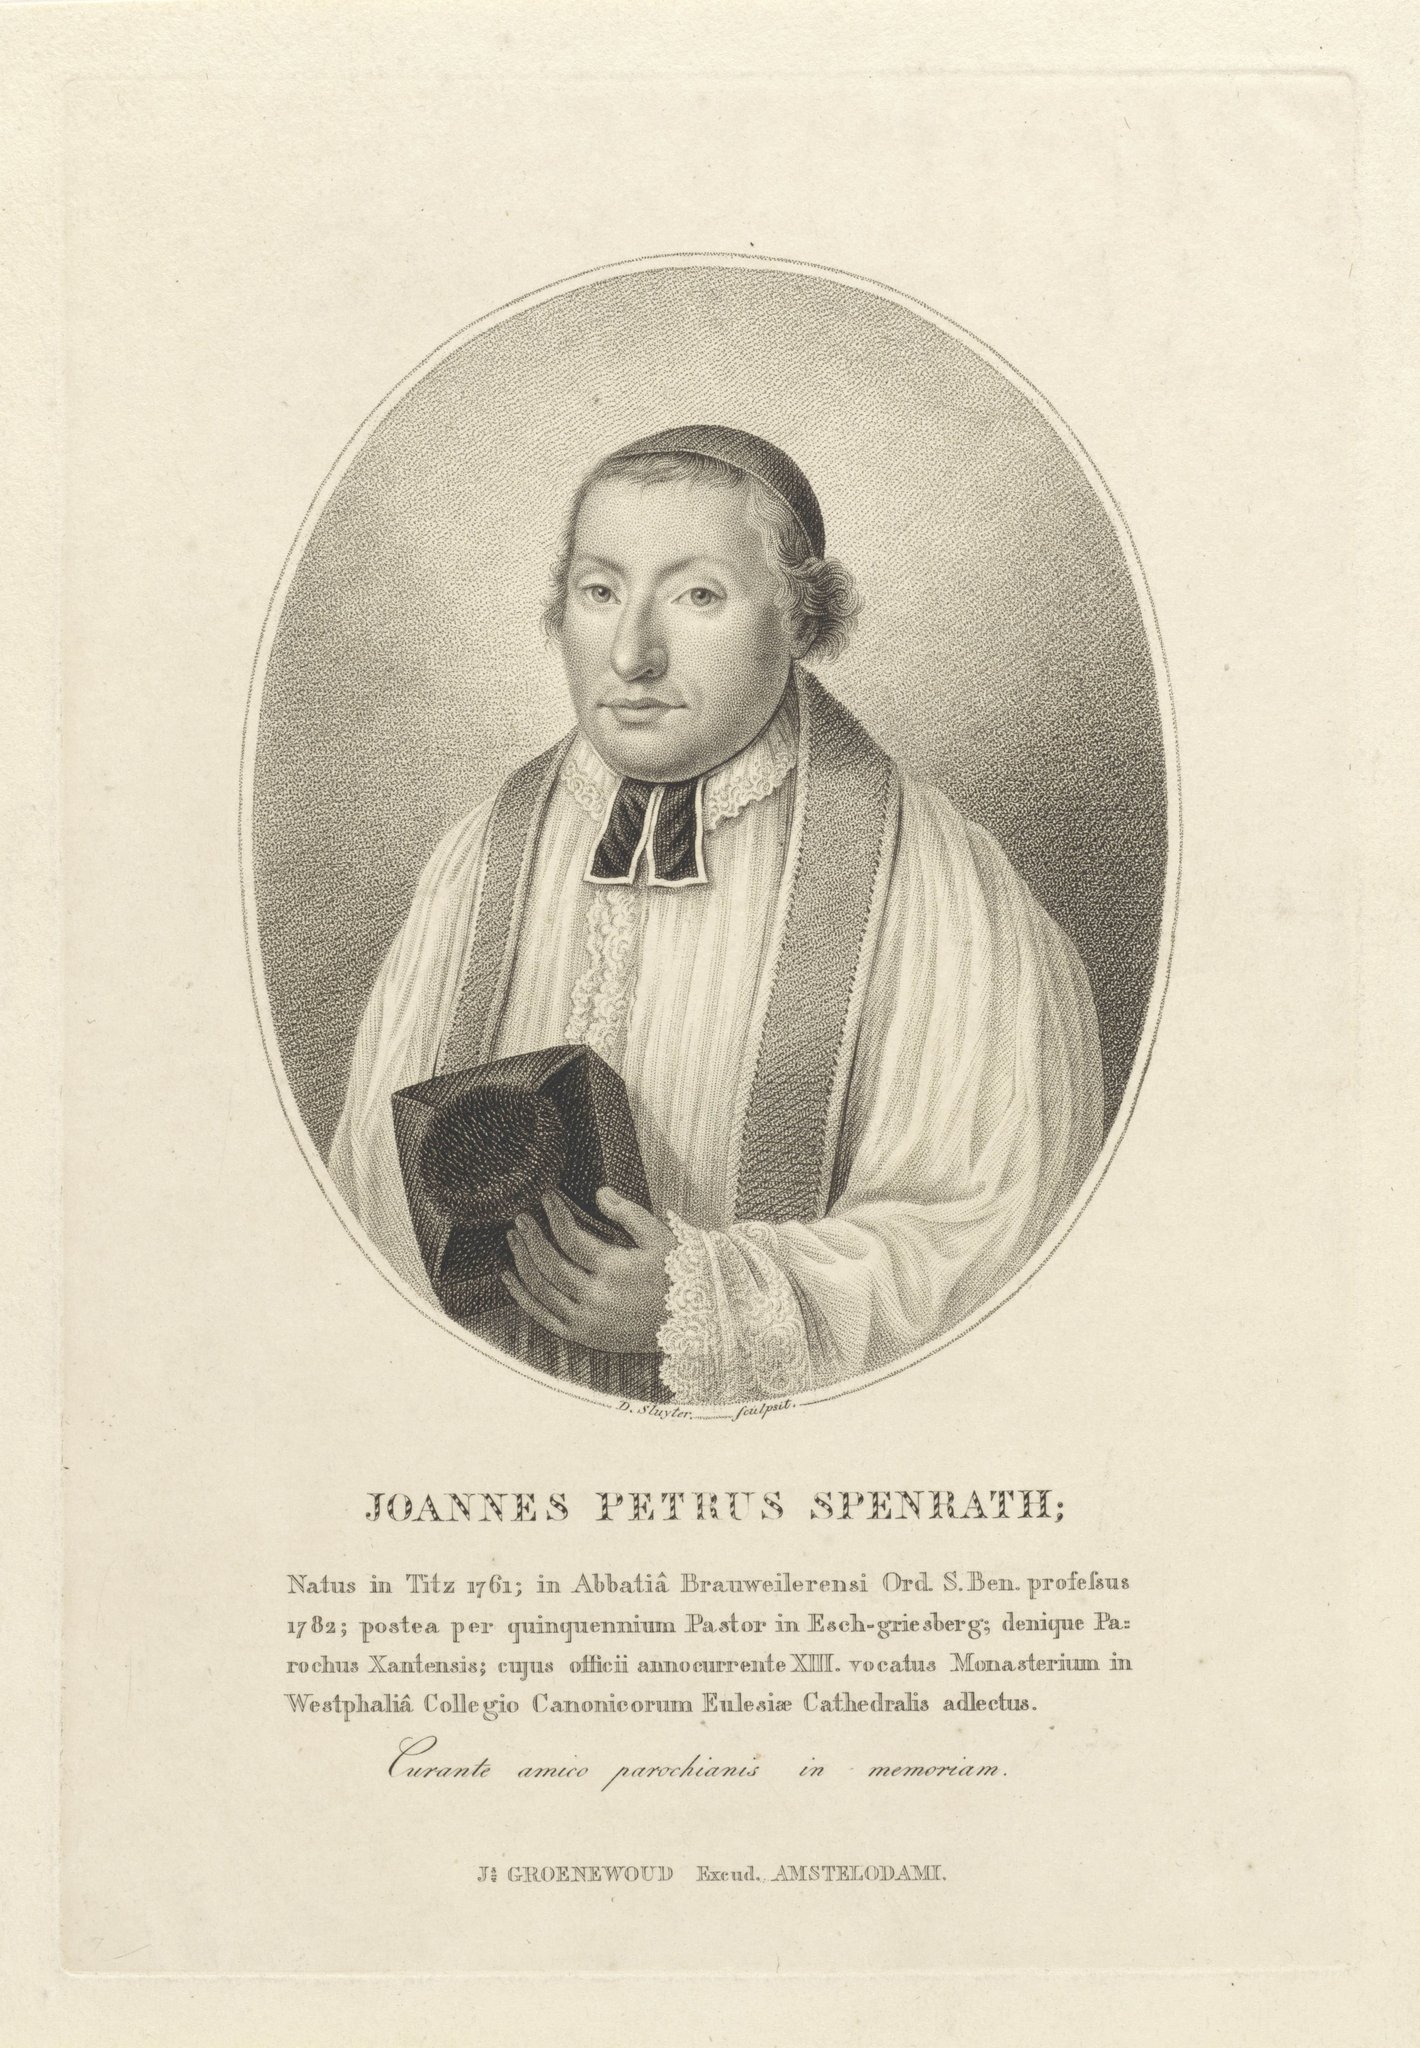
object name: print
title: Portret van de Duitse katholieke theoloog Johannes Petrus Spenrath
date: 1813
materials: paper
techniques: engraving, etching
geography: amsterdam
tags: pastoor, joannes petrus spenrath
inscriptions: collector's mark: Lugt 2228